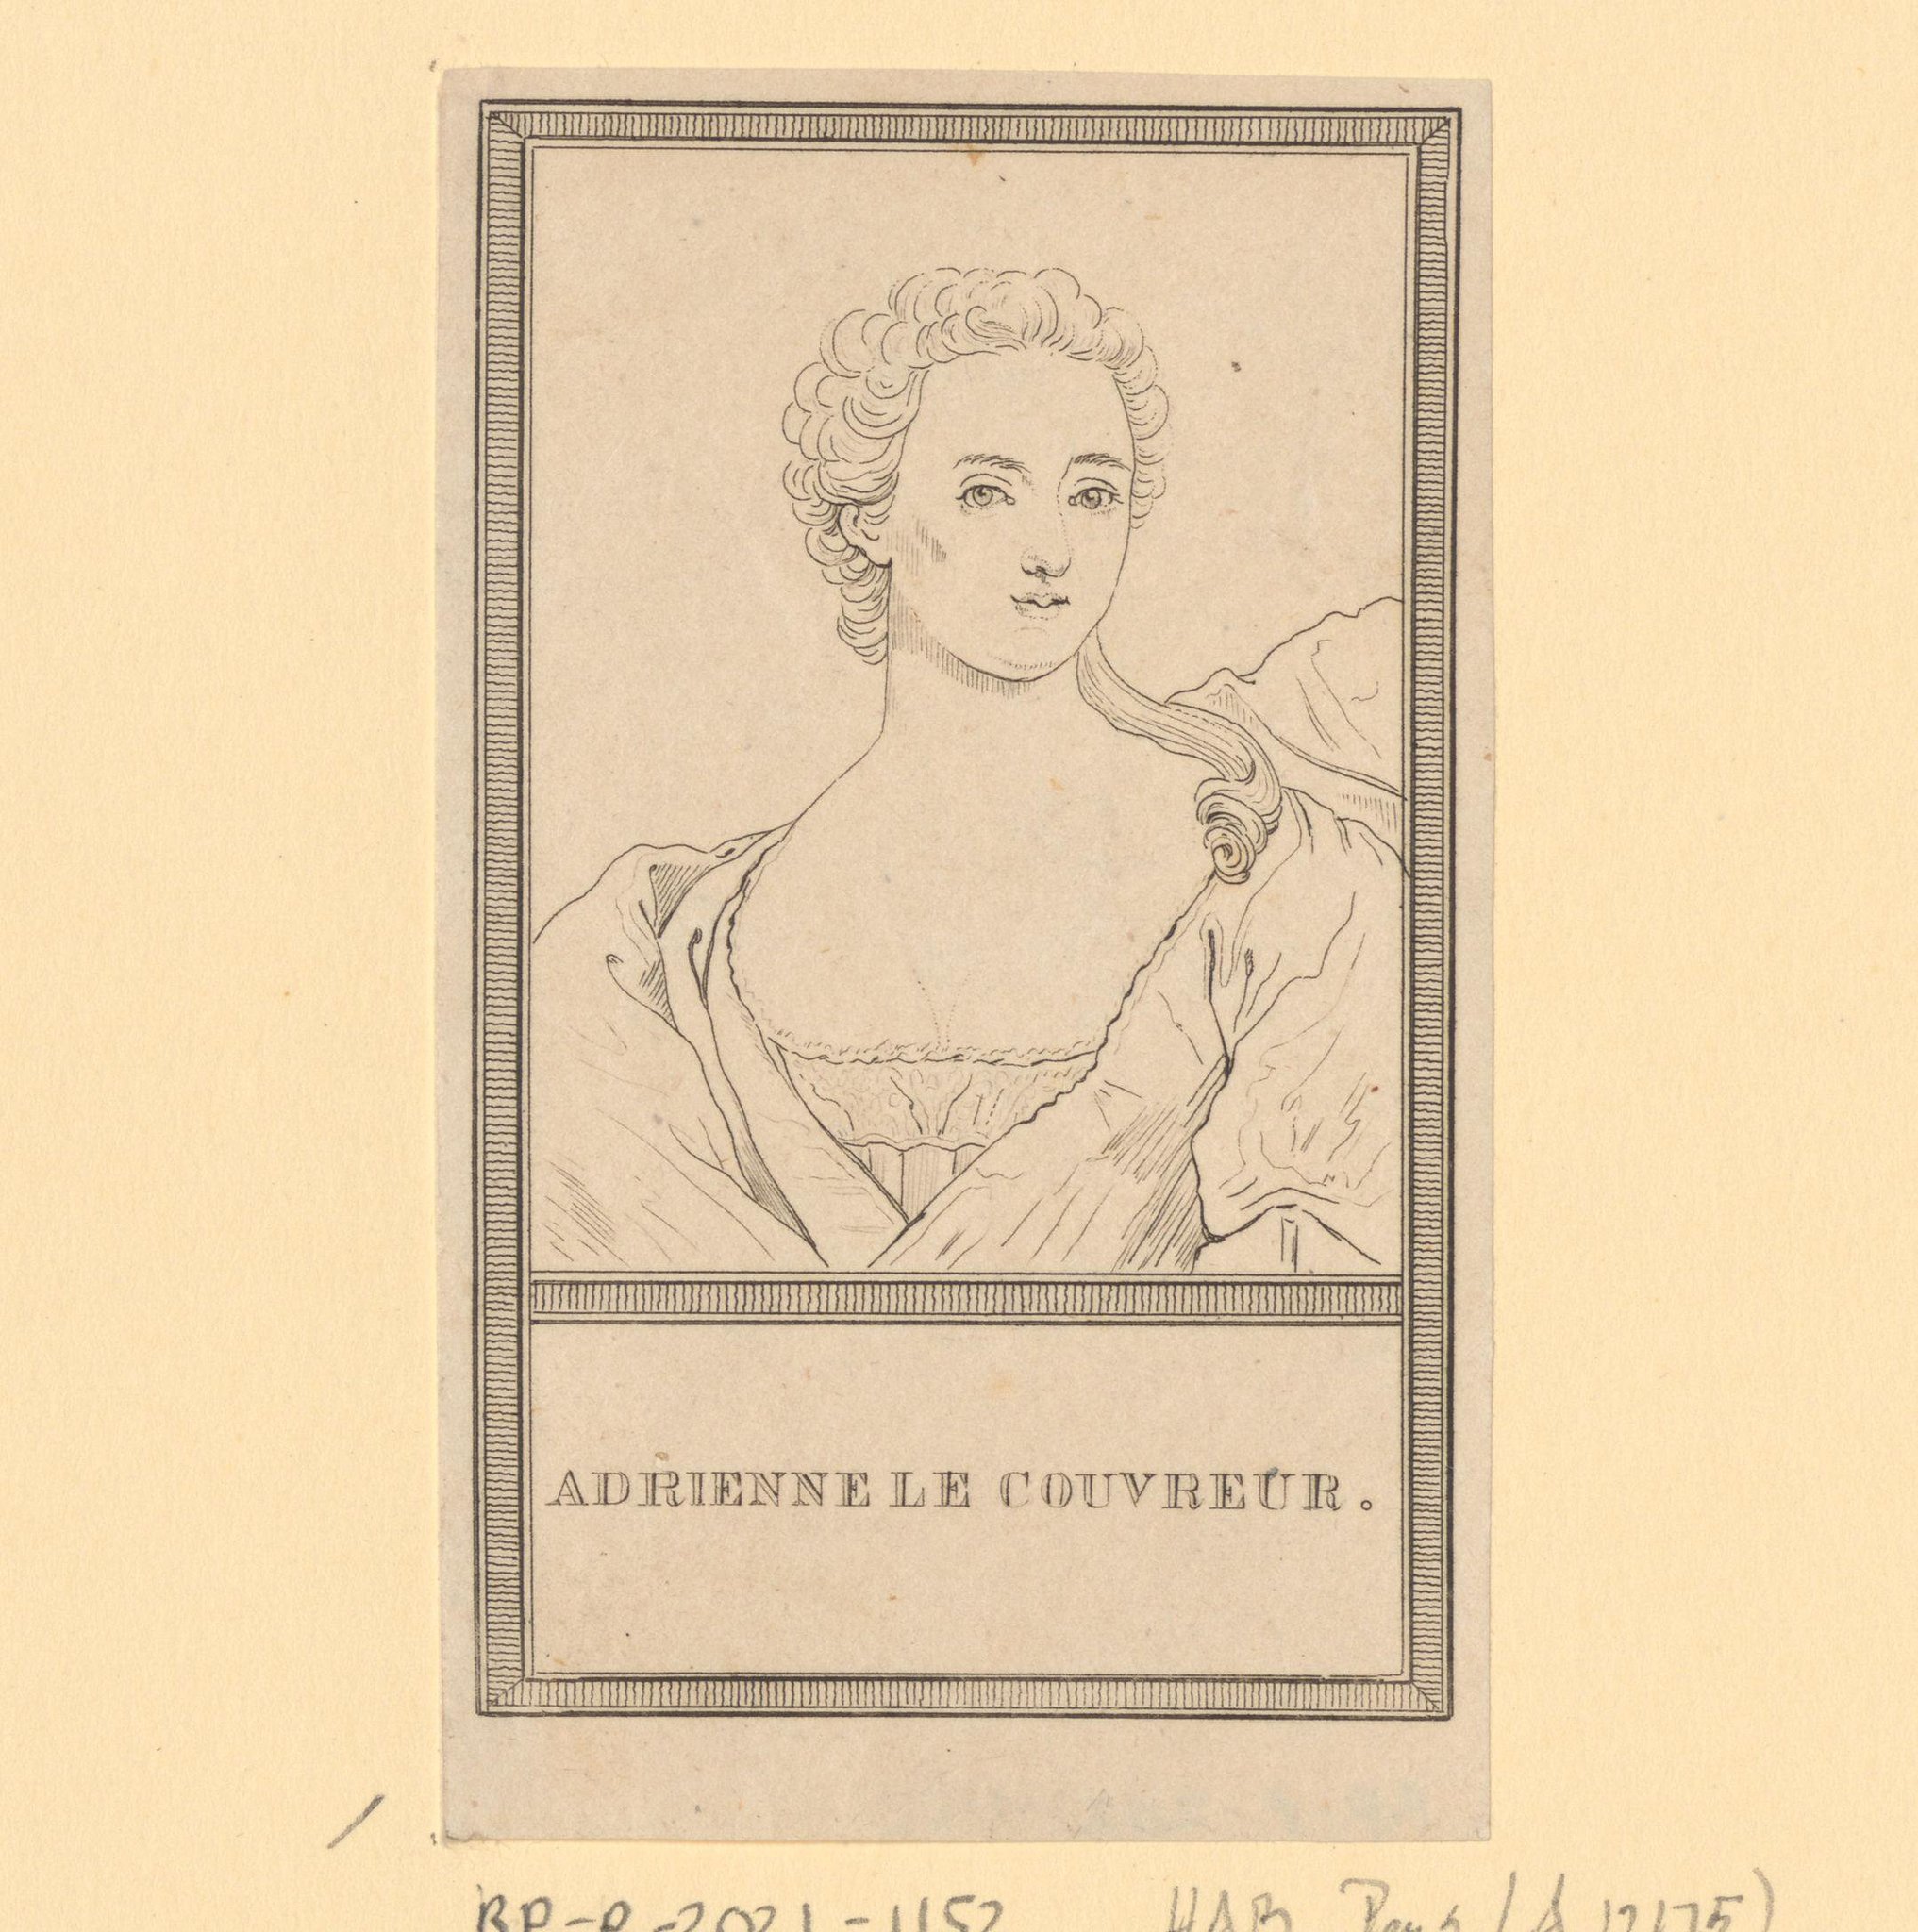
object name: book illustration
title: Portret van Adrienne Lecouvreur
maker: Anonymous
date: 1805-1811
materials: paper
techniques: etching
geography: paris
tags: historical persons, portrait of actor, actress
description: Prent waarschijnlijk uit een deel van: Galerie historique des hommes les plus célèbres (...). Parijs: Charles Paul Landon, 1805-1811.